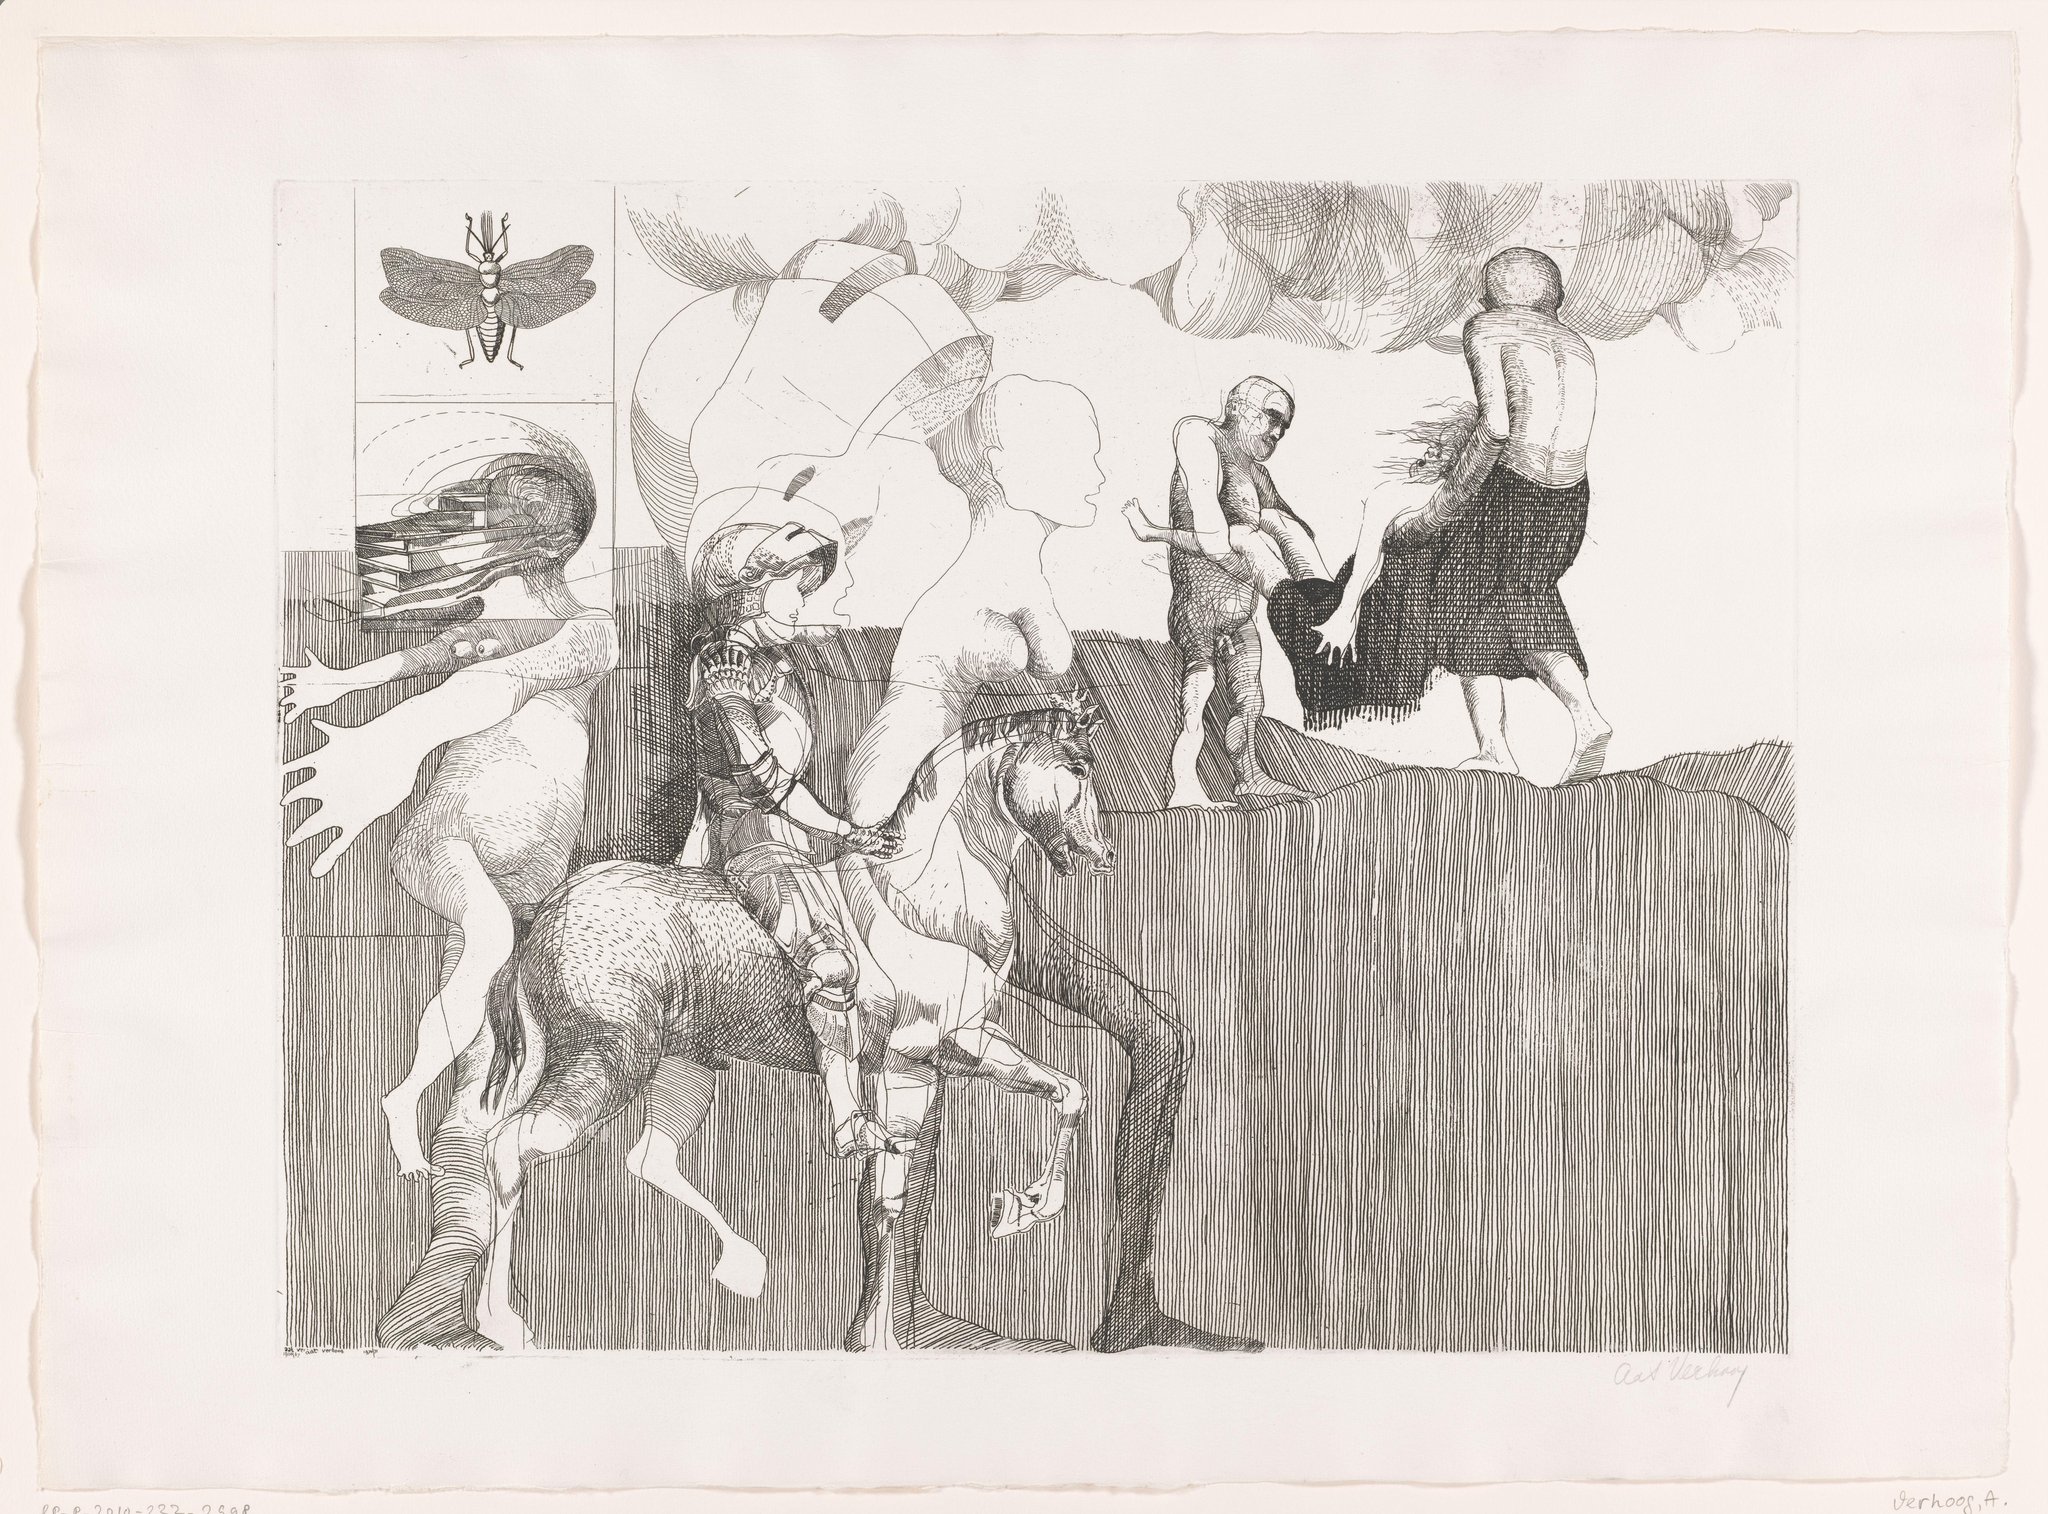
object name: print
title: Ridder te paard en vlieg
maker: aat verhoog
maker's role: print maker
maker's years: 1933-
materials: paper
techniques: etching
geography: amsterdam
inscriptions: signature: ‘Aat Verhoog’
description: Links een ridder te paard en gedetailleerd weergegeven insect, rechts twee mensen die een derde figuur bij de arm- en knieholtes vasthouden.